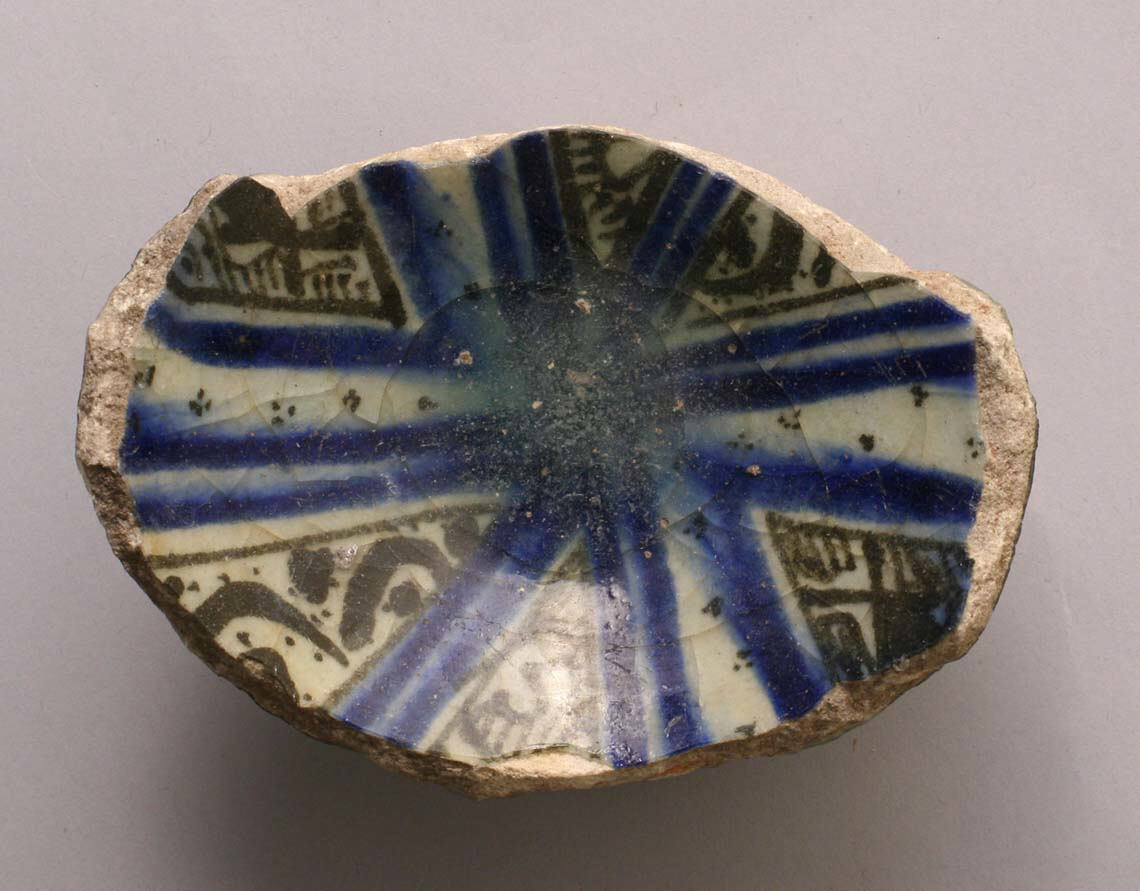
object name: ceramic fragment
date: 1301-1400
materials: glaze, stonepaste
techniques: painting, polychrome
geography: syria